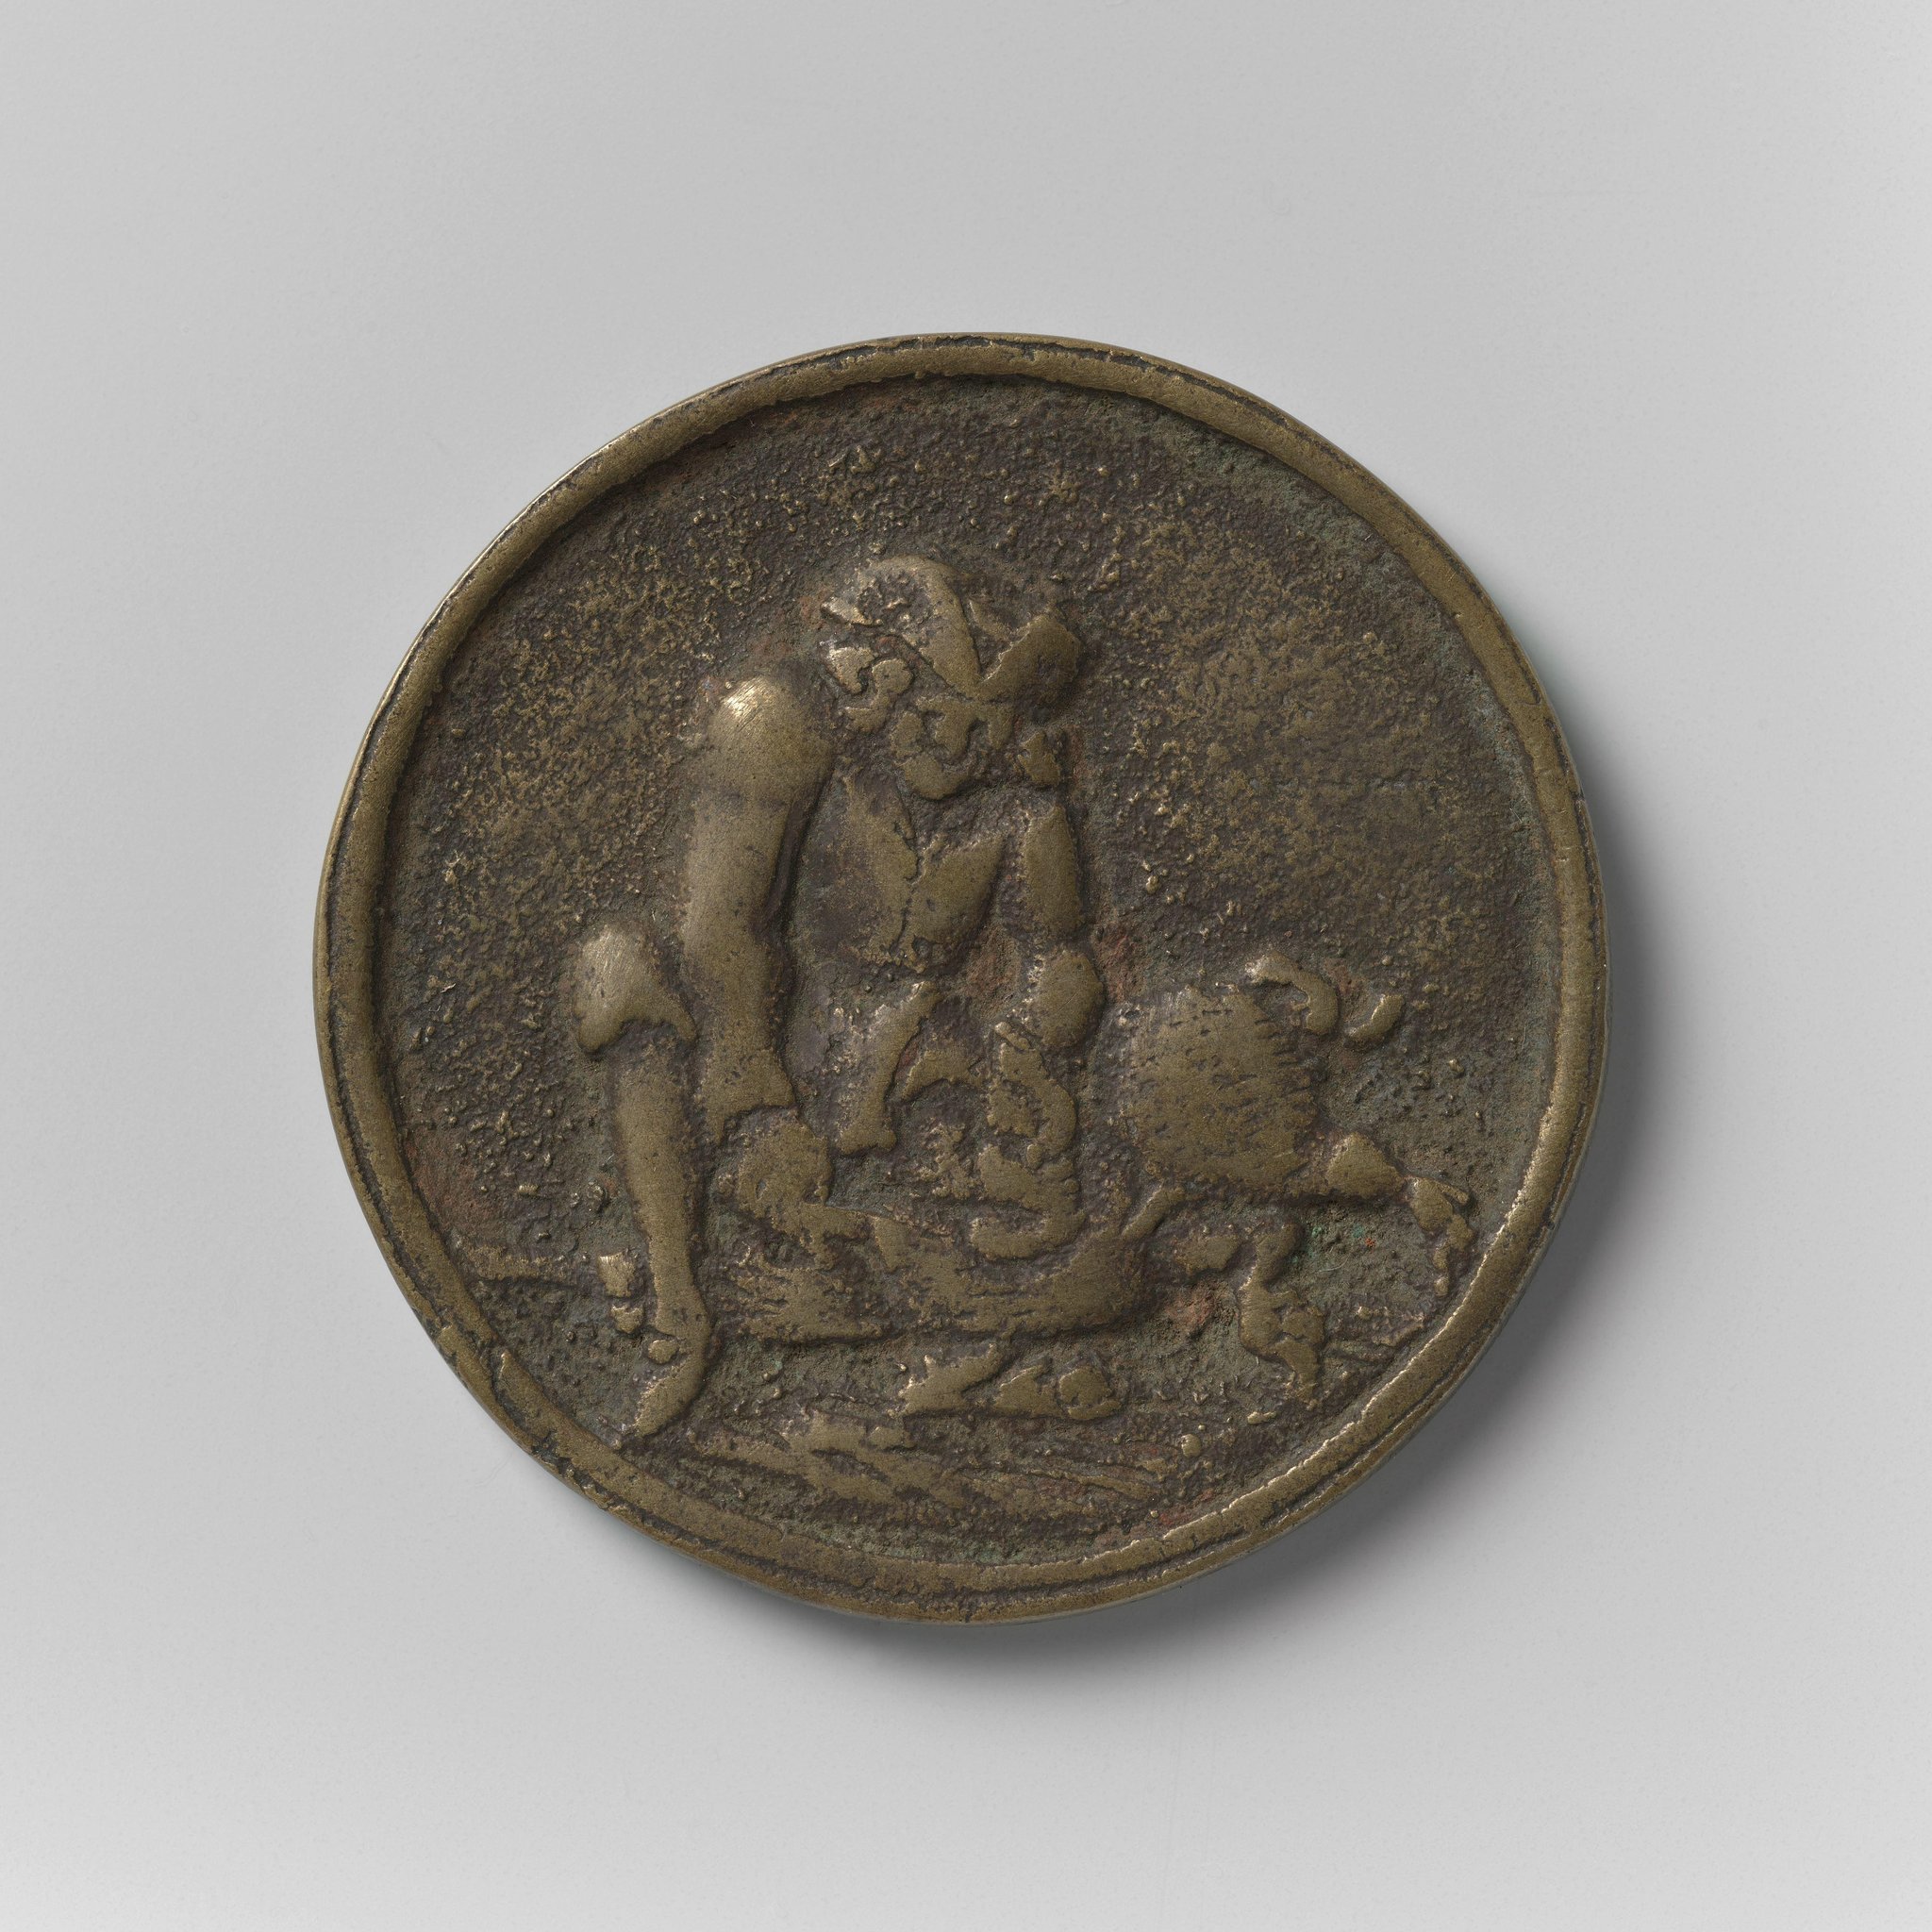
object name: medal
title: Presentiepenning van het Spek- en Varkensslagersgilde te Amsterdam, 1751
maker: ludolph cloppenburg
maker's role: caster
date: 1751-1795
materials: brass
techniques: casting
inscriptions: inscription: ‘HARMANUS / HALDERIT / 1795’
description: Gegoten messing penning, op de voorzijde een varkensslager met varken, op de keerzijde een gekroond wapenschild Amsterdam met dragers boven een inscriptieruimte, op naam van Harmanus Halderit 1795